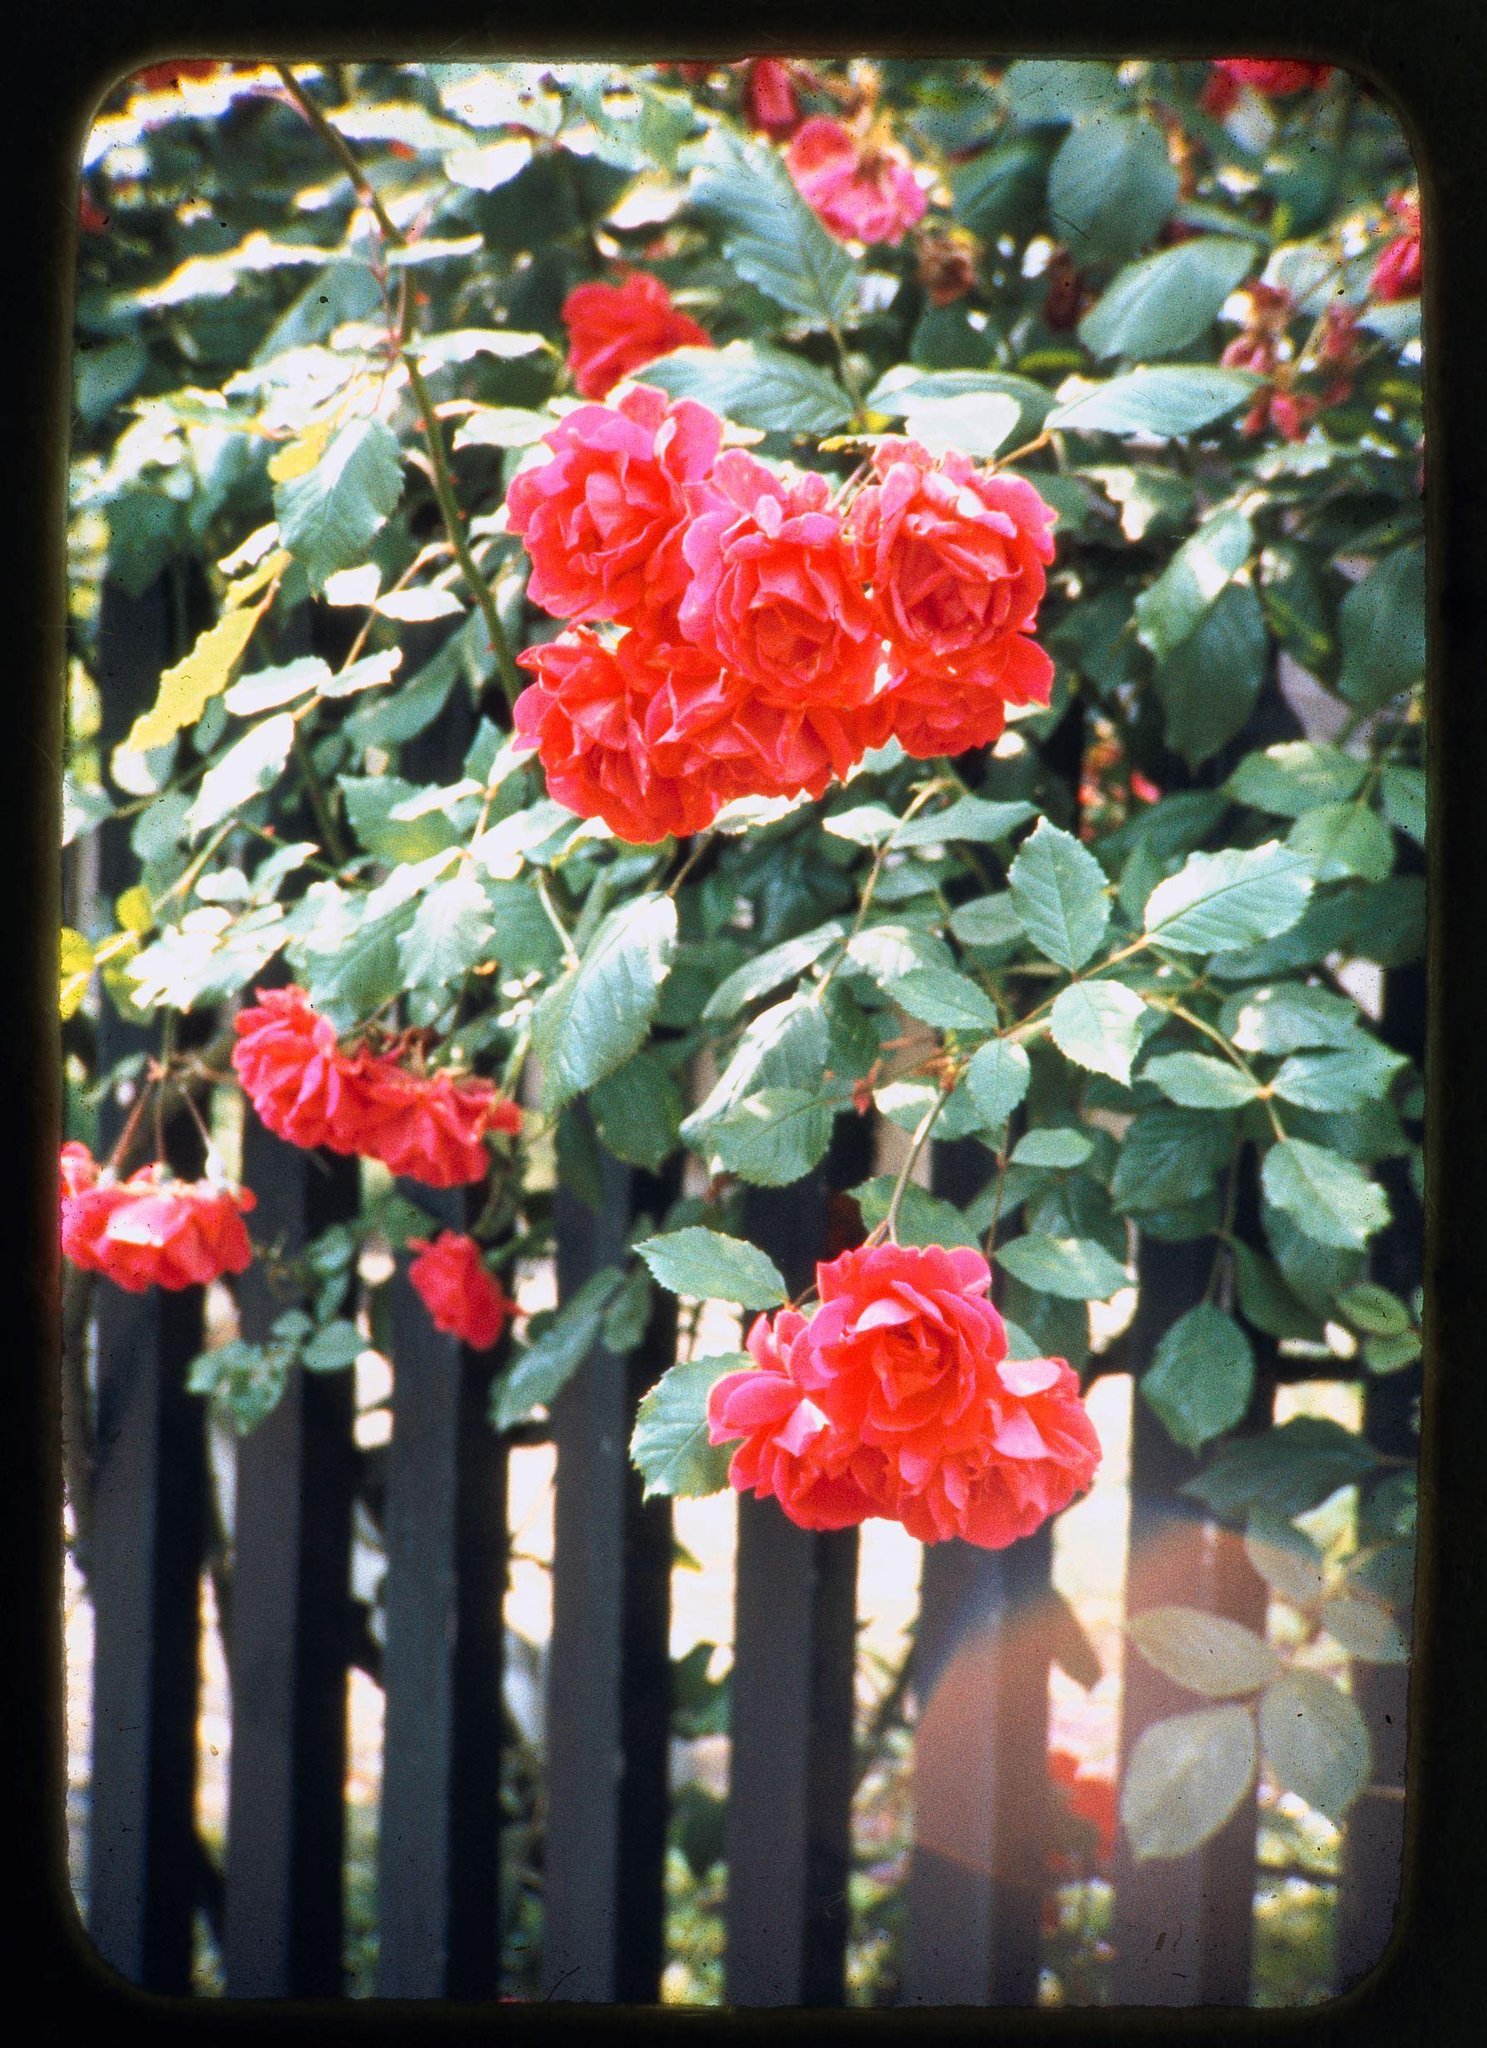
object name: photograph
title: Bloeiende rozenstruik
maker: Anonymous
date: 1950-1975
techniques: slide